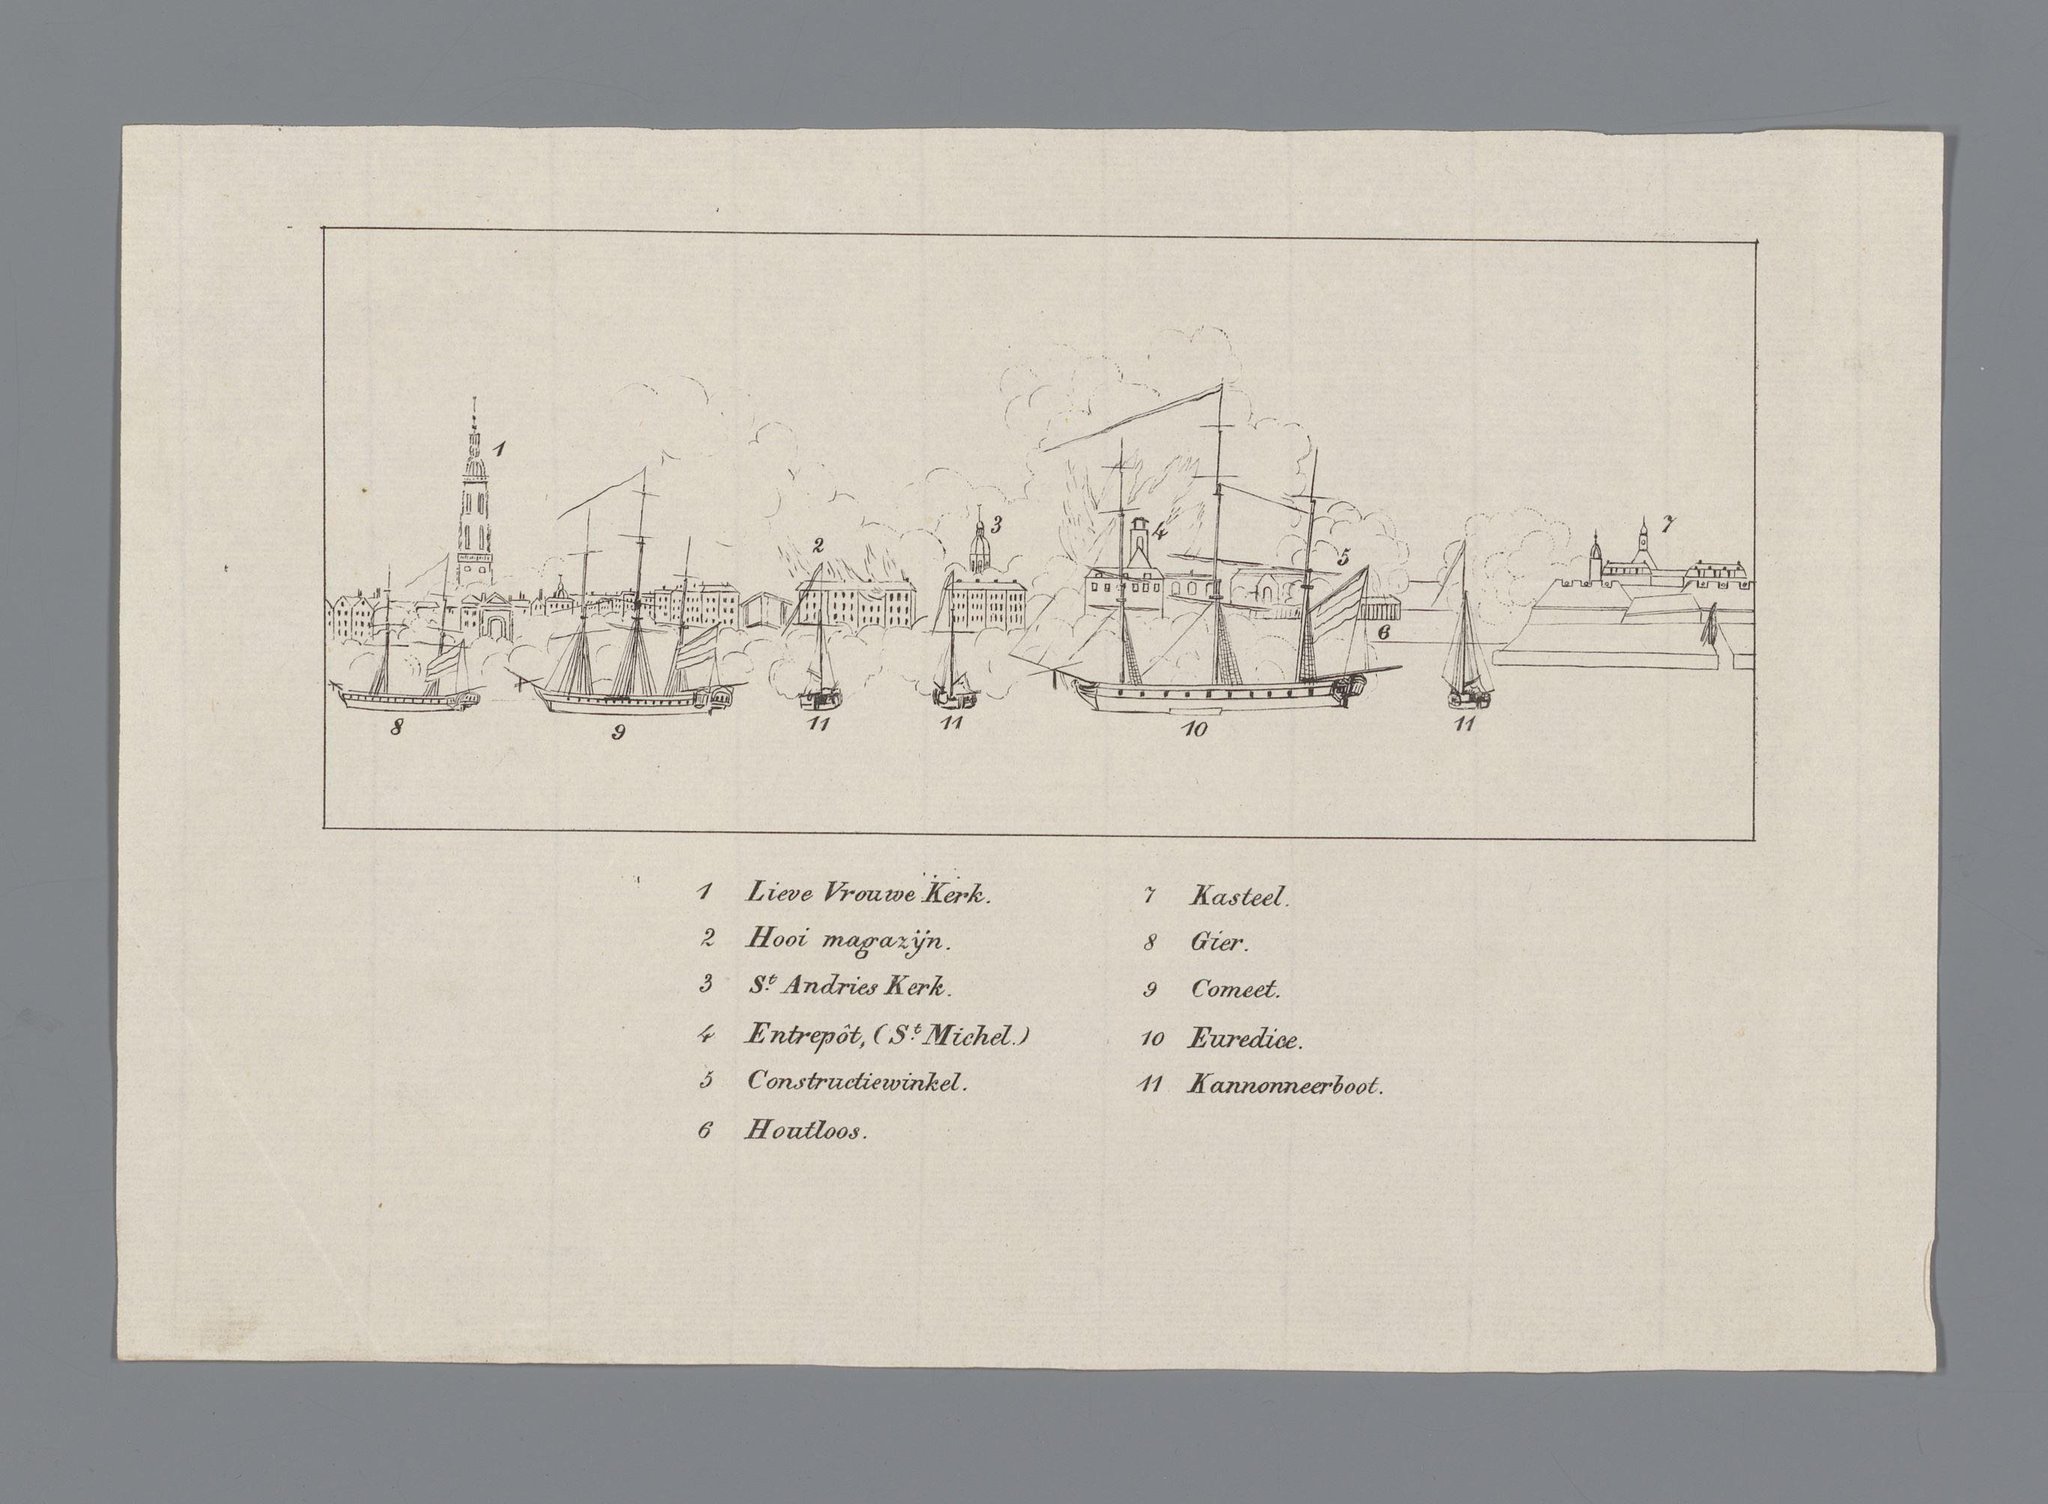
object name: print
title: Sleutel bij de prent van de beschieting van Antwerpen, 1830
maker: Anonymous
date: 1830-1831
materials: paper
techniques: lithograph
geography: netherlands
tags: david hendrik baron chassé, bombardment ~ siege, bombardment, antwerp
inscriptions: collector's mark: Lugt 2228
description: Sleutel voor de prent van het bombardement van Antwerpen door Nederlandse oorlogsschepen onder bevel van baron Chassé, op 27 oktober 1830. Voorstelling in contouren met legenda 1-11.